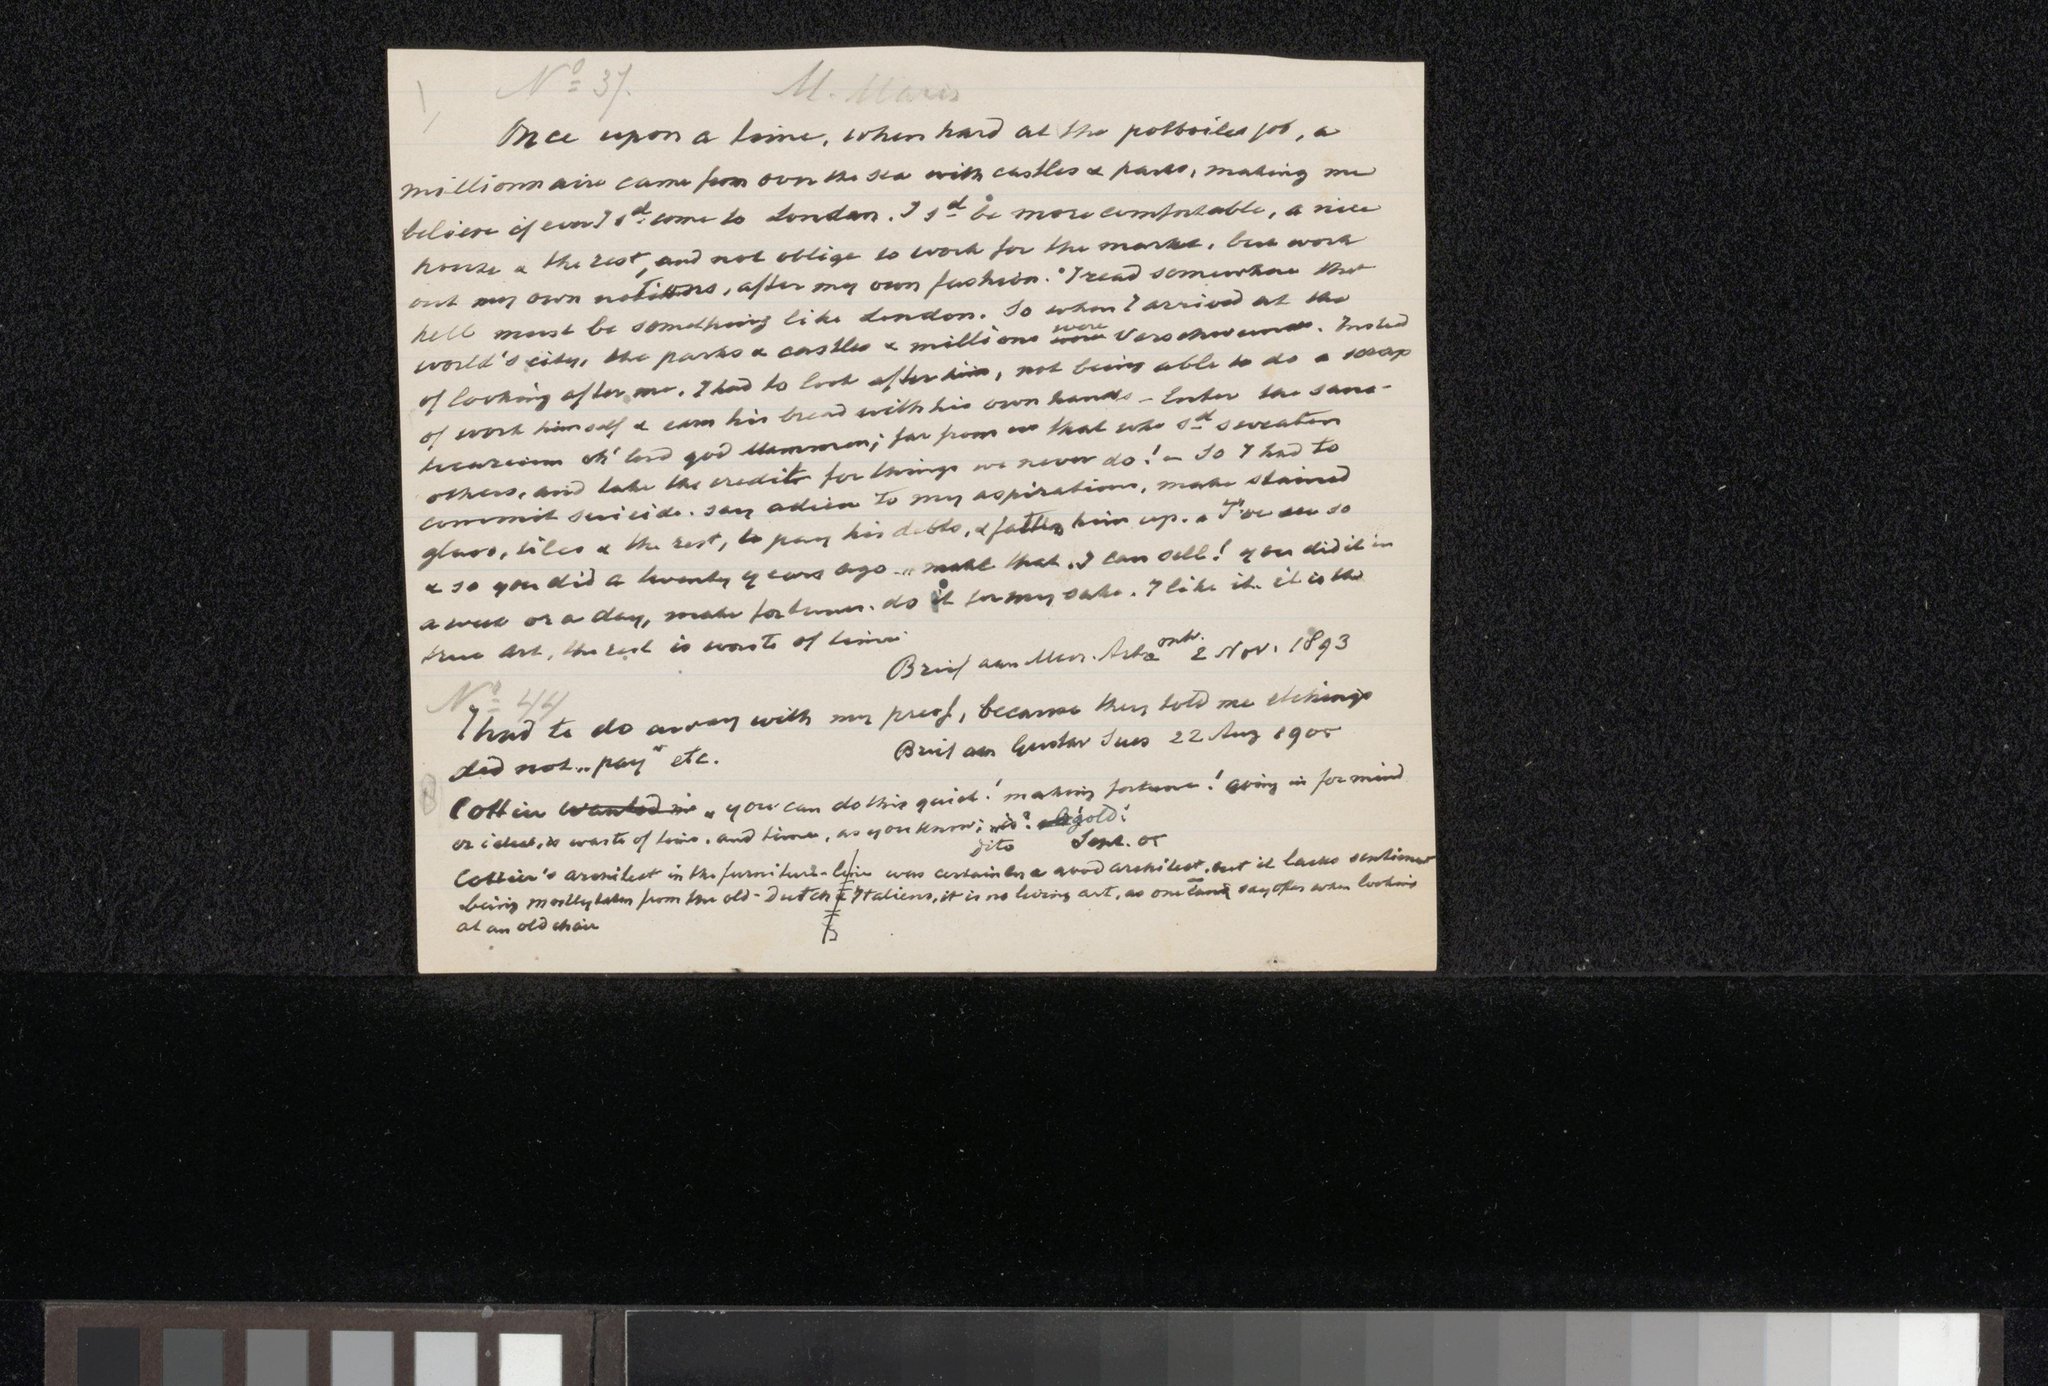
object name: letter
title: Transcripties van (delen van) brieven aan mevrouw Artz en aan Friedrich Gustav Julius Süs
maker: pieter haverkorn van rijsewijk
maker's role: museumdirecteur, publicist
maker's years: 1839-1919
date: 1905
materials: ink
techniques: pen, writing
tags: glasgow, painter, draughtsman, daniel cottier, art trade, art shop, the graphic arts, london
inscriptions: collector's mark: Lugt 2233